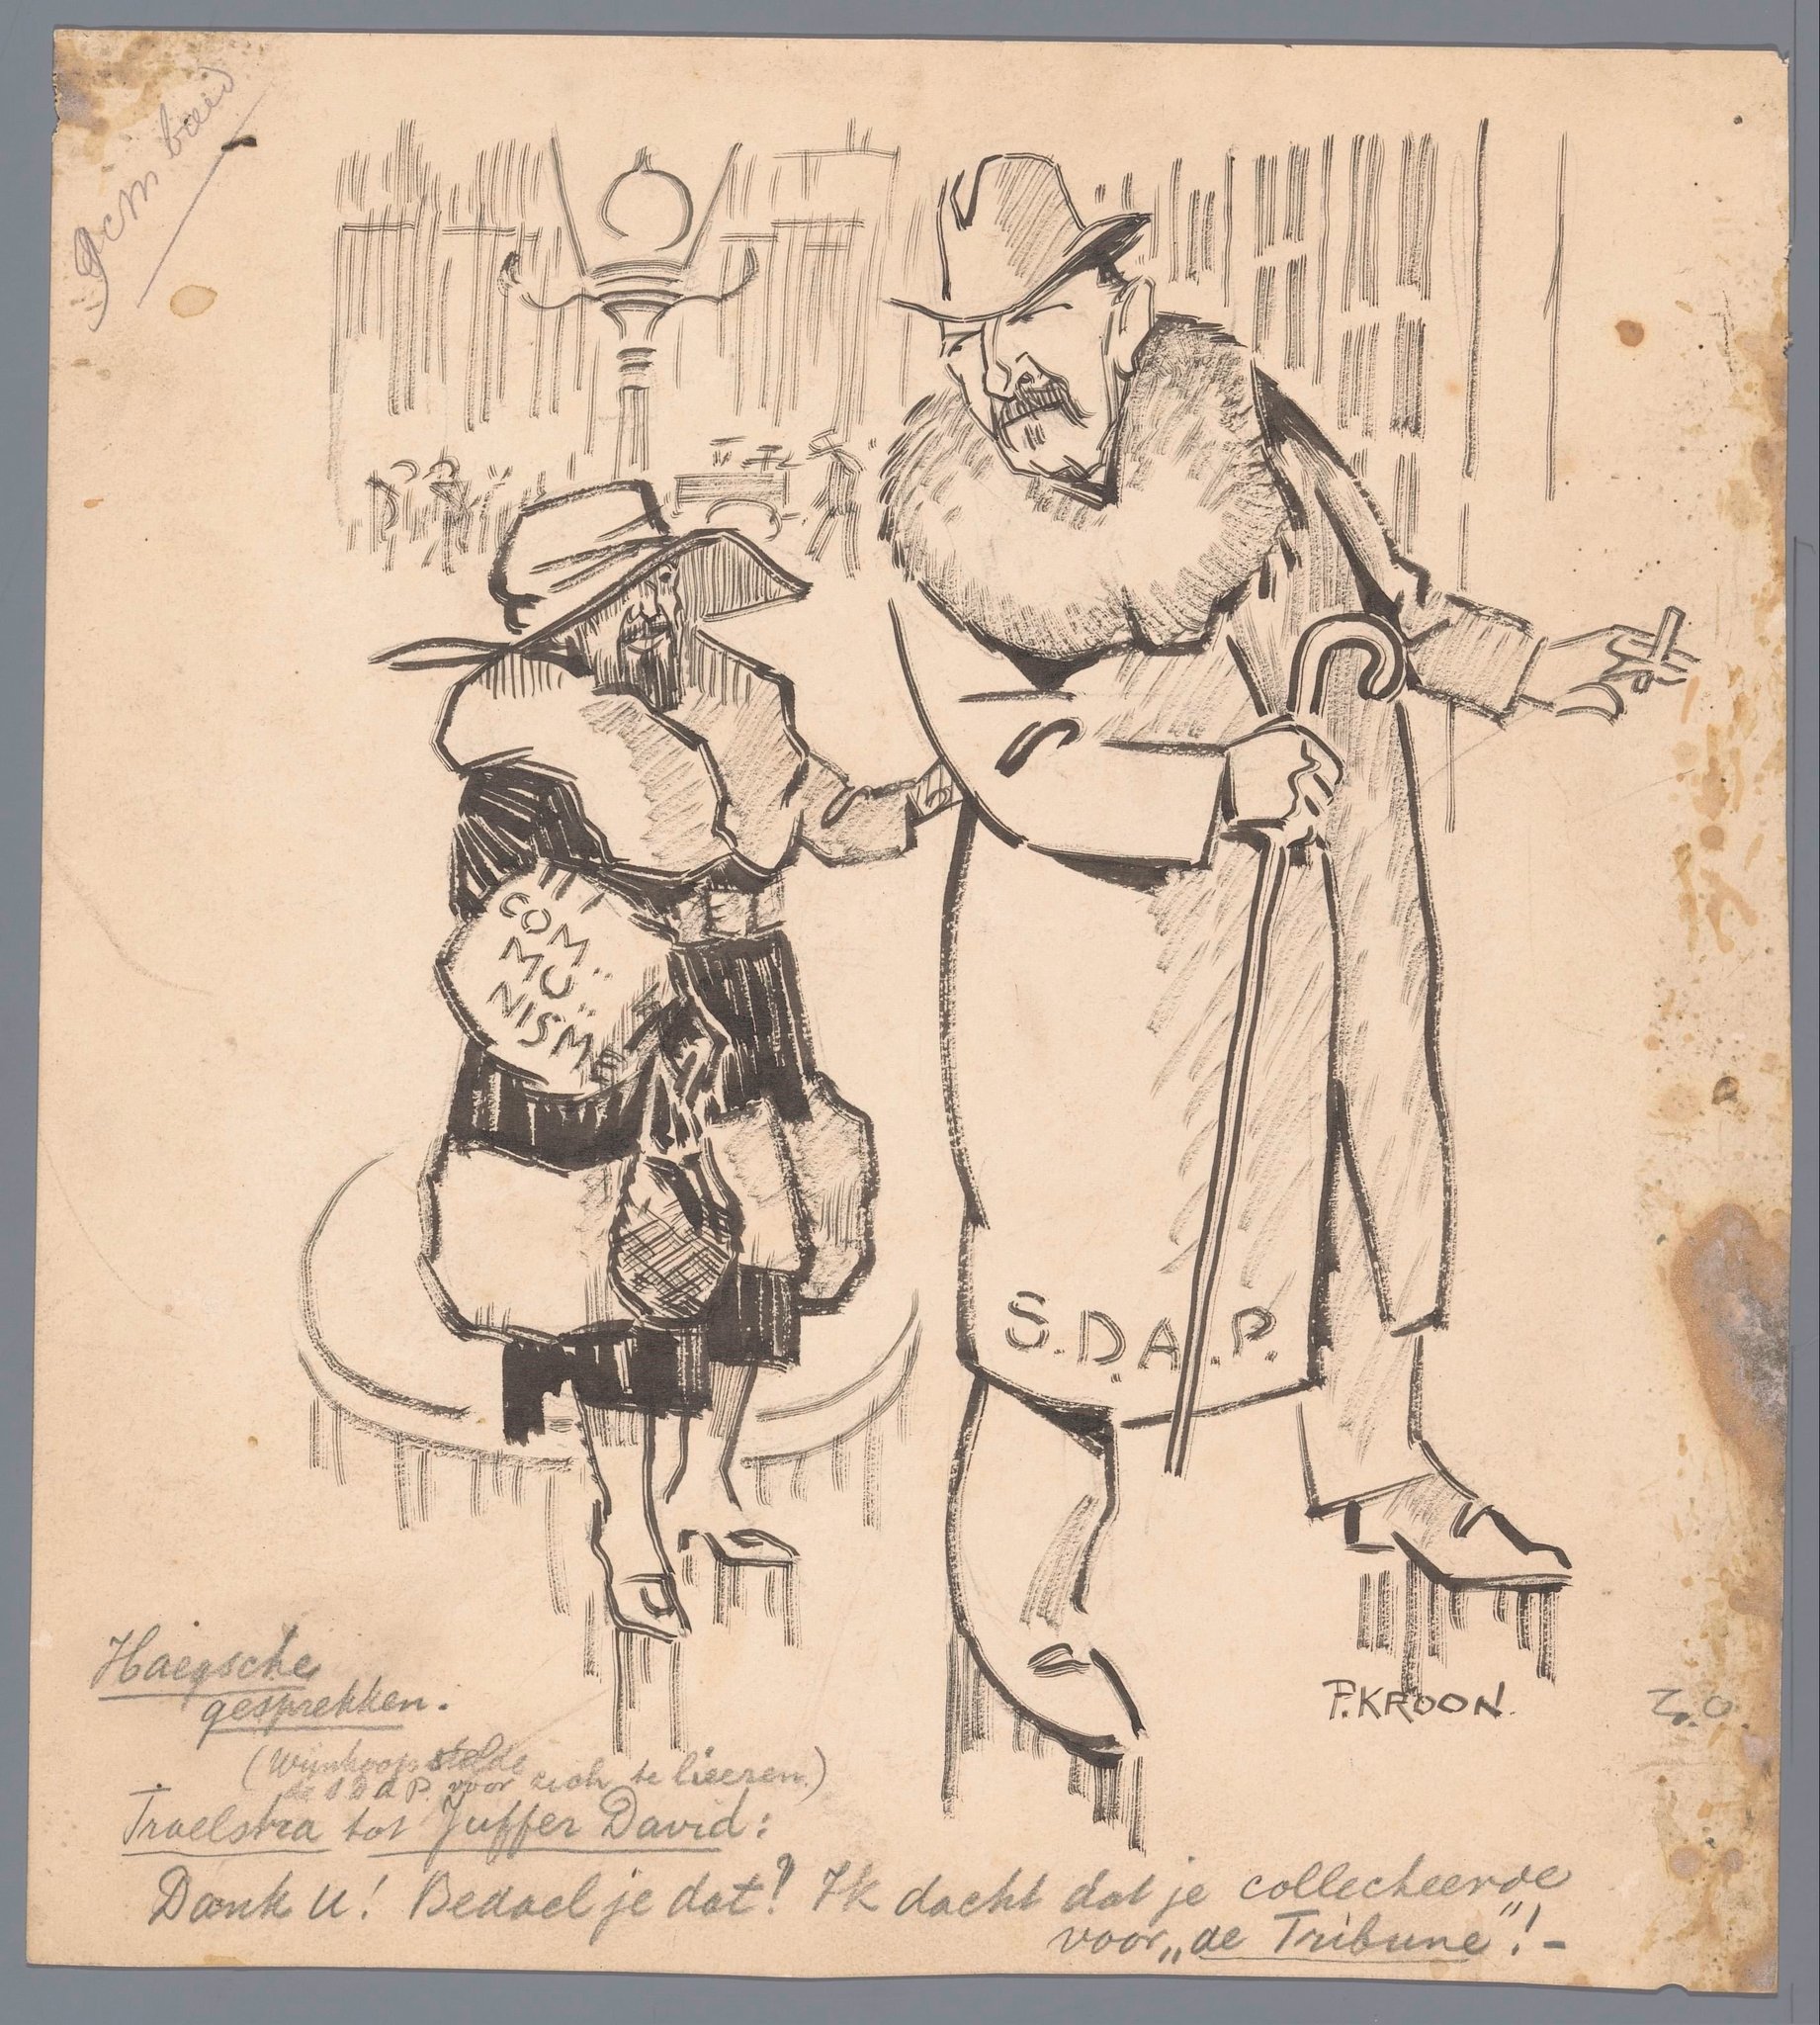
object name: cartoon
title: Haegsche gesprekken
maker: patricq kroon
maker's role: draughtsman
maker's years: 1862-1941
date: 1919-1925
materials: paper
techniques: pen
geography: netherlands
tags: politician, political parties, political caricatures and satires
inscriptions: number: ‘14683’, inscription: ‘Wijnkoop deed aan de S.D.A.P. het voorstel de partijen te verbinden tot een eenheidsfront tegen de Reactie enz.’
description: David Wijnkoop (als vrouw) klampt P.J. Troelstra op straat aan. In verband met het voorstel van Wijnkoop om zijn Communistische Partij Holland te verbinden aan de SDAP. Ontwerp voor een politieke spotprent.